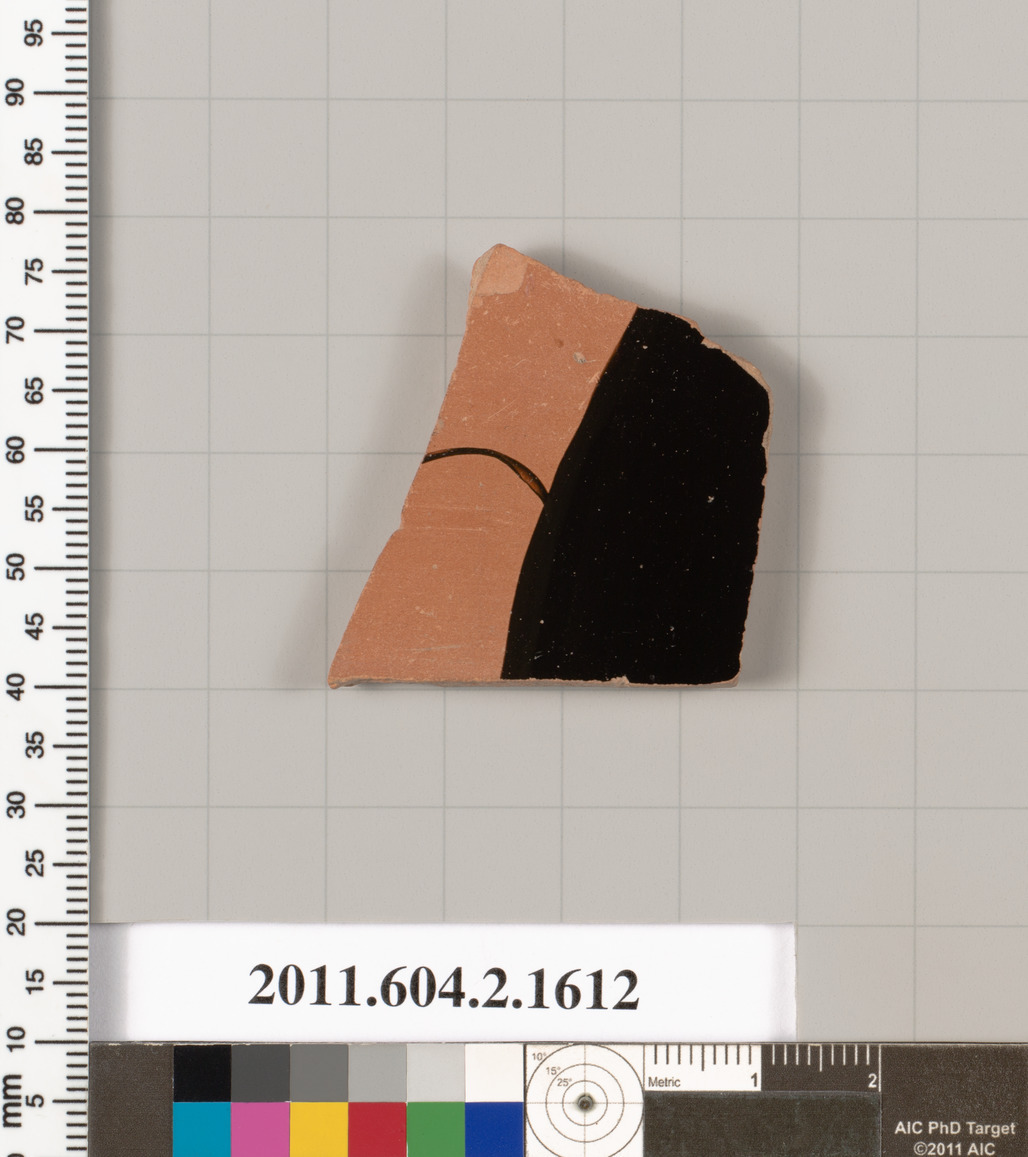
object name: skyphos fragment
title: Terracotta fragment of a skyphos (deep drinking cup)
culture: greek, attic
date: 460-440 BCE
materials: terracotta